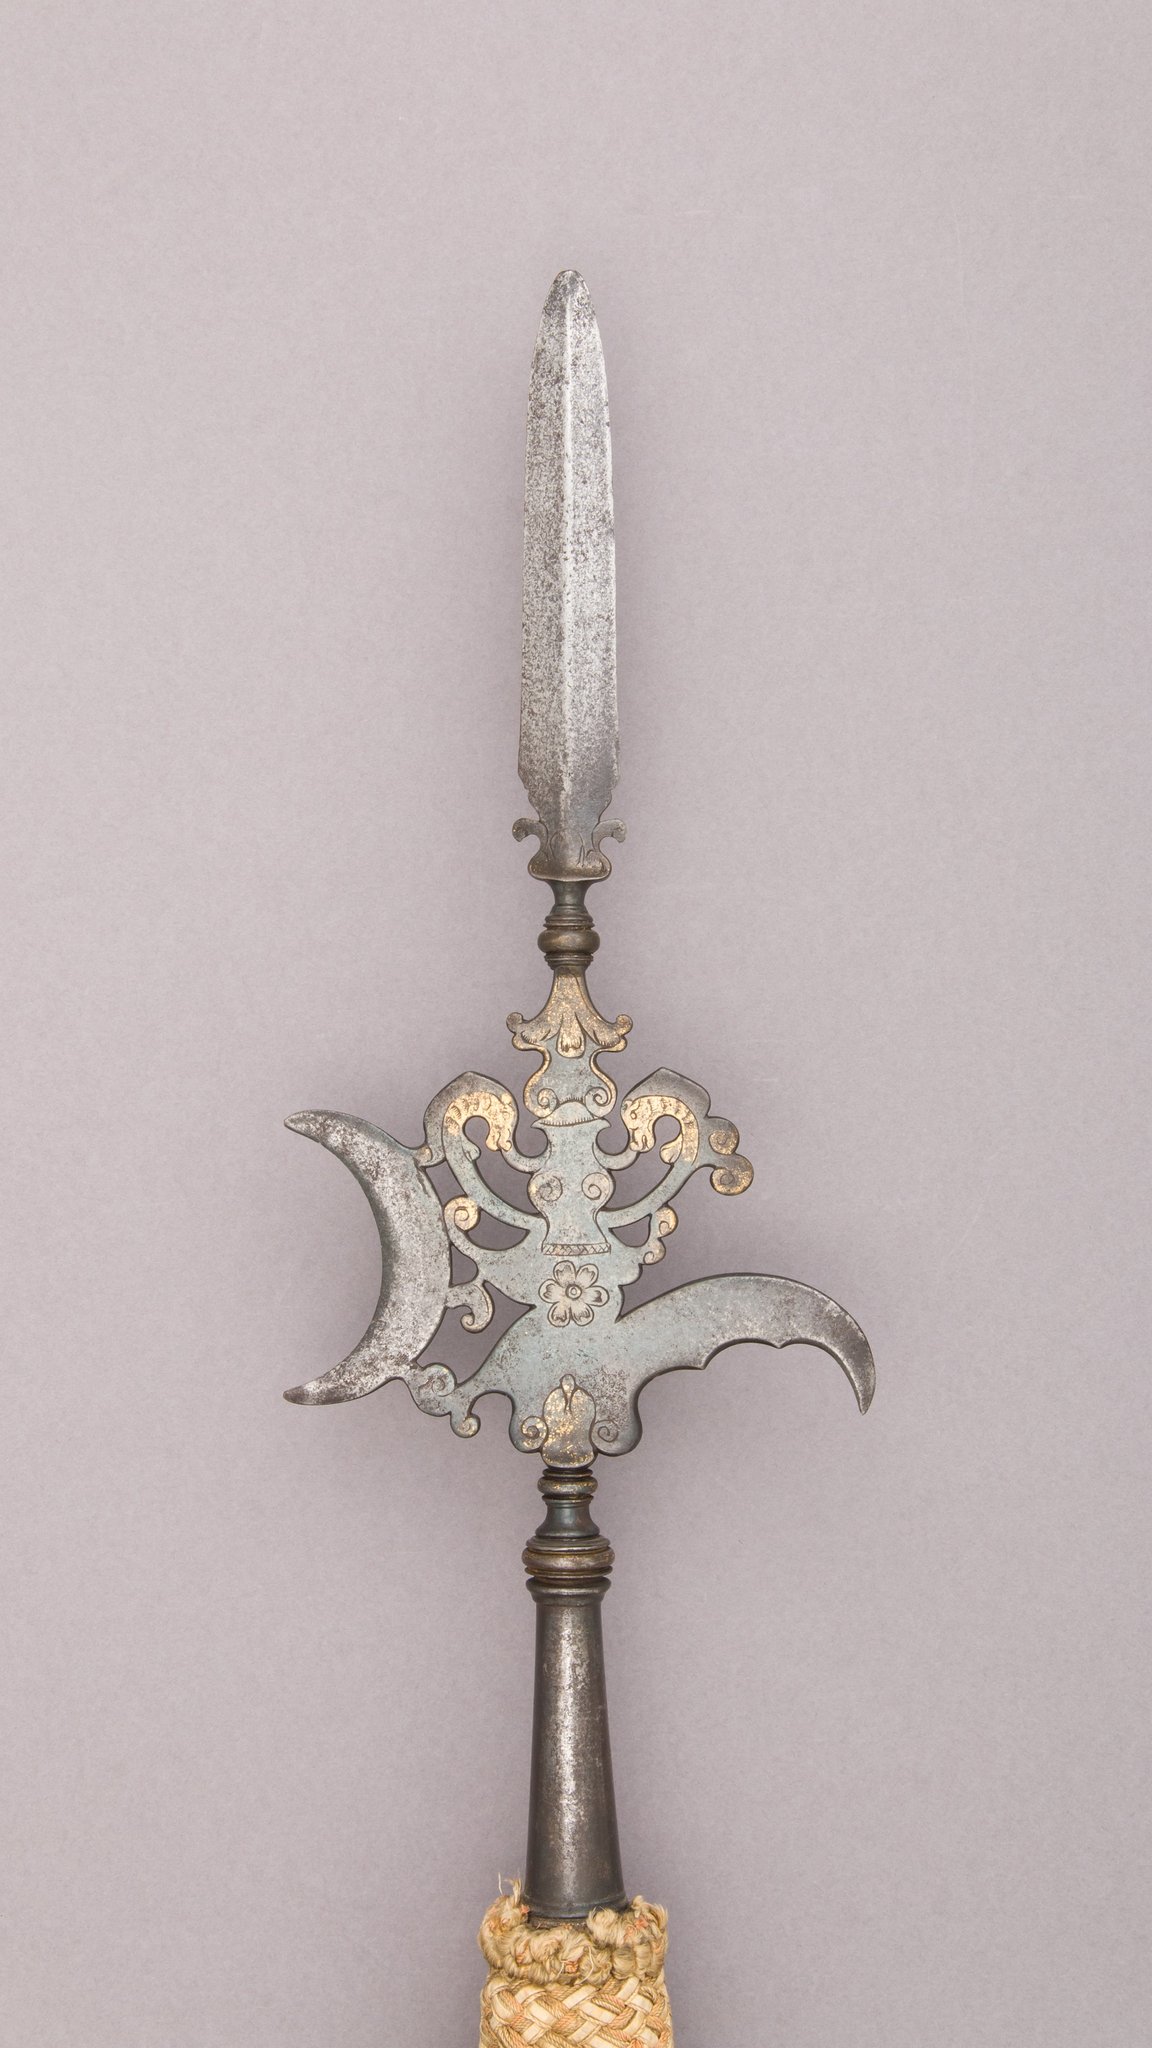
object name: partisan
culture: british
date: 1701-1800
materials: gold, steel, textile, wood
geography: england